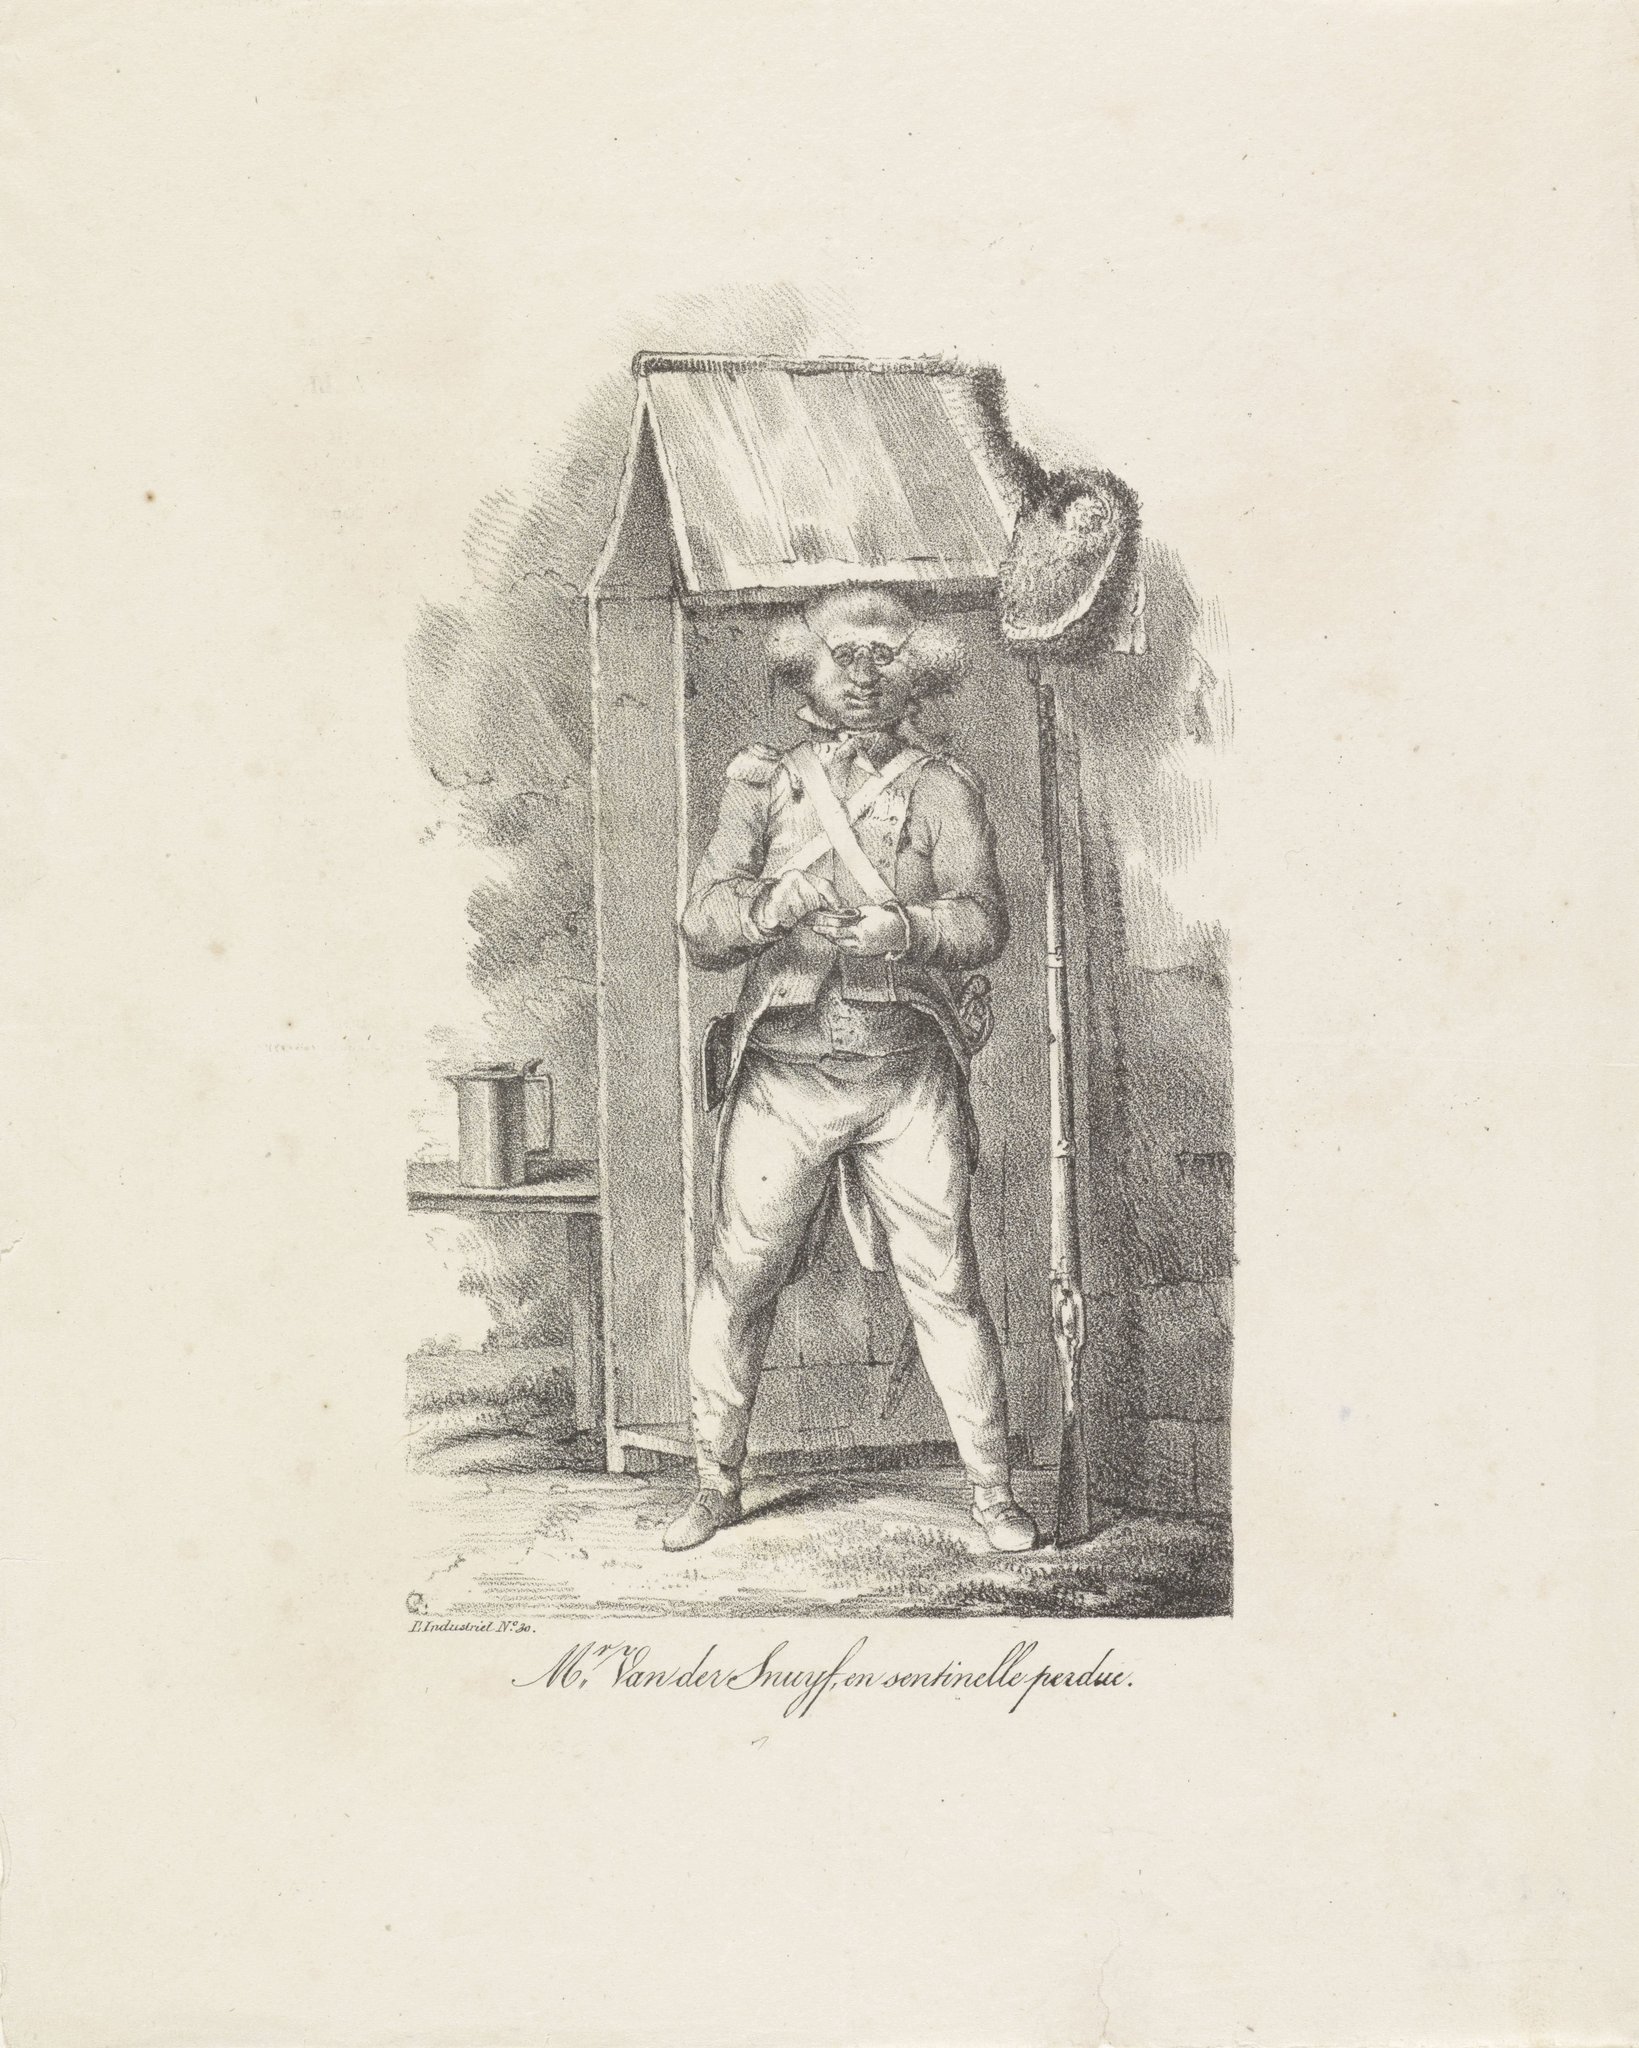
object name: print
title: Spotprenten op de wanverhoudingen binnen de Belgische Schutterijen, 1828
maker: Anonymous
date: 1828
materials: paper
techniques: lithograph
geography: southern netherlands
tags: the soldier; the soldier's life, belgium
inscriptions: collector's mark: Lugt 2228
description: Van der Snuijff op wacht. Onderdeel van een serie van ca. 24 spotprenten uit 1828 op de wanverhoudingen binnen de Belgische schutterijen door de maatschappelijke ongelijkheid binnen het korps, na de reorganisatie ingevoerd op 11 april 1827.